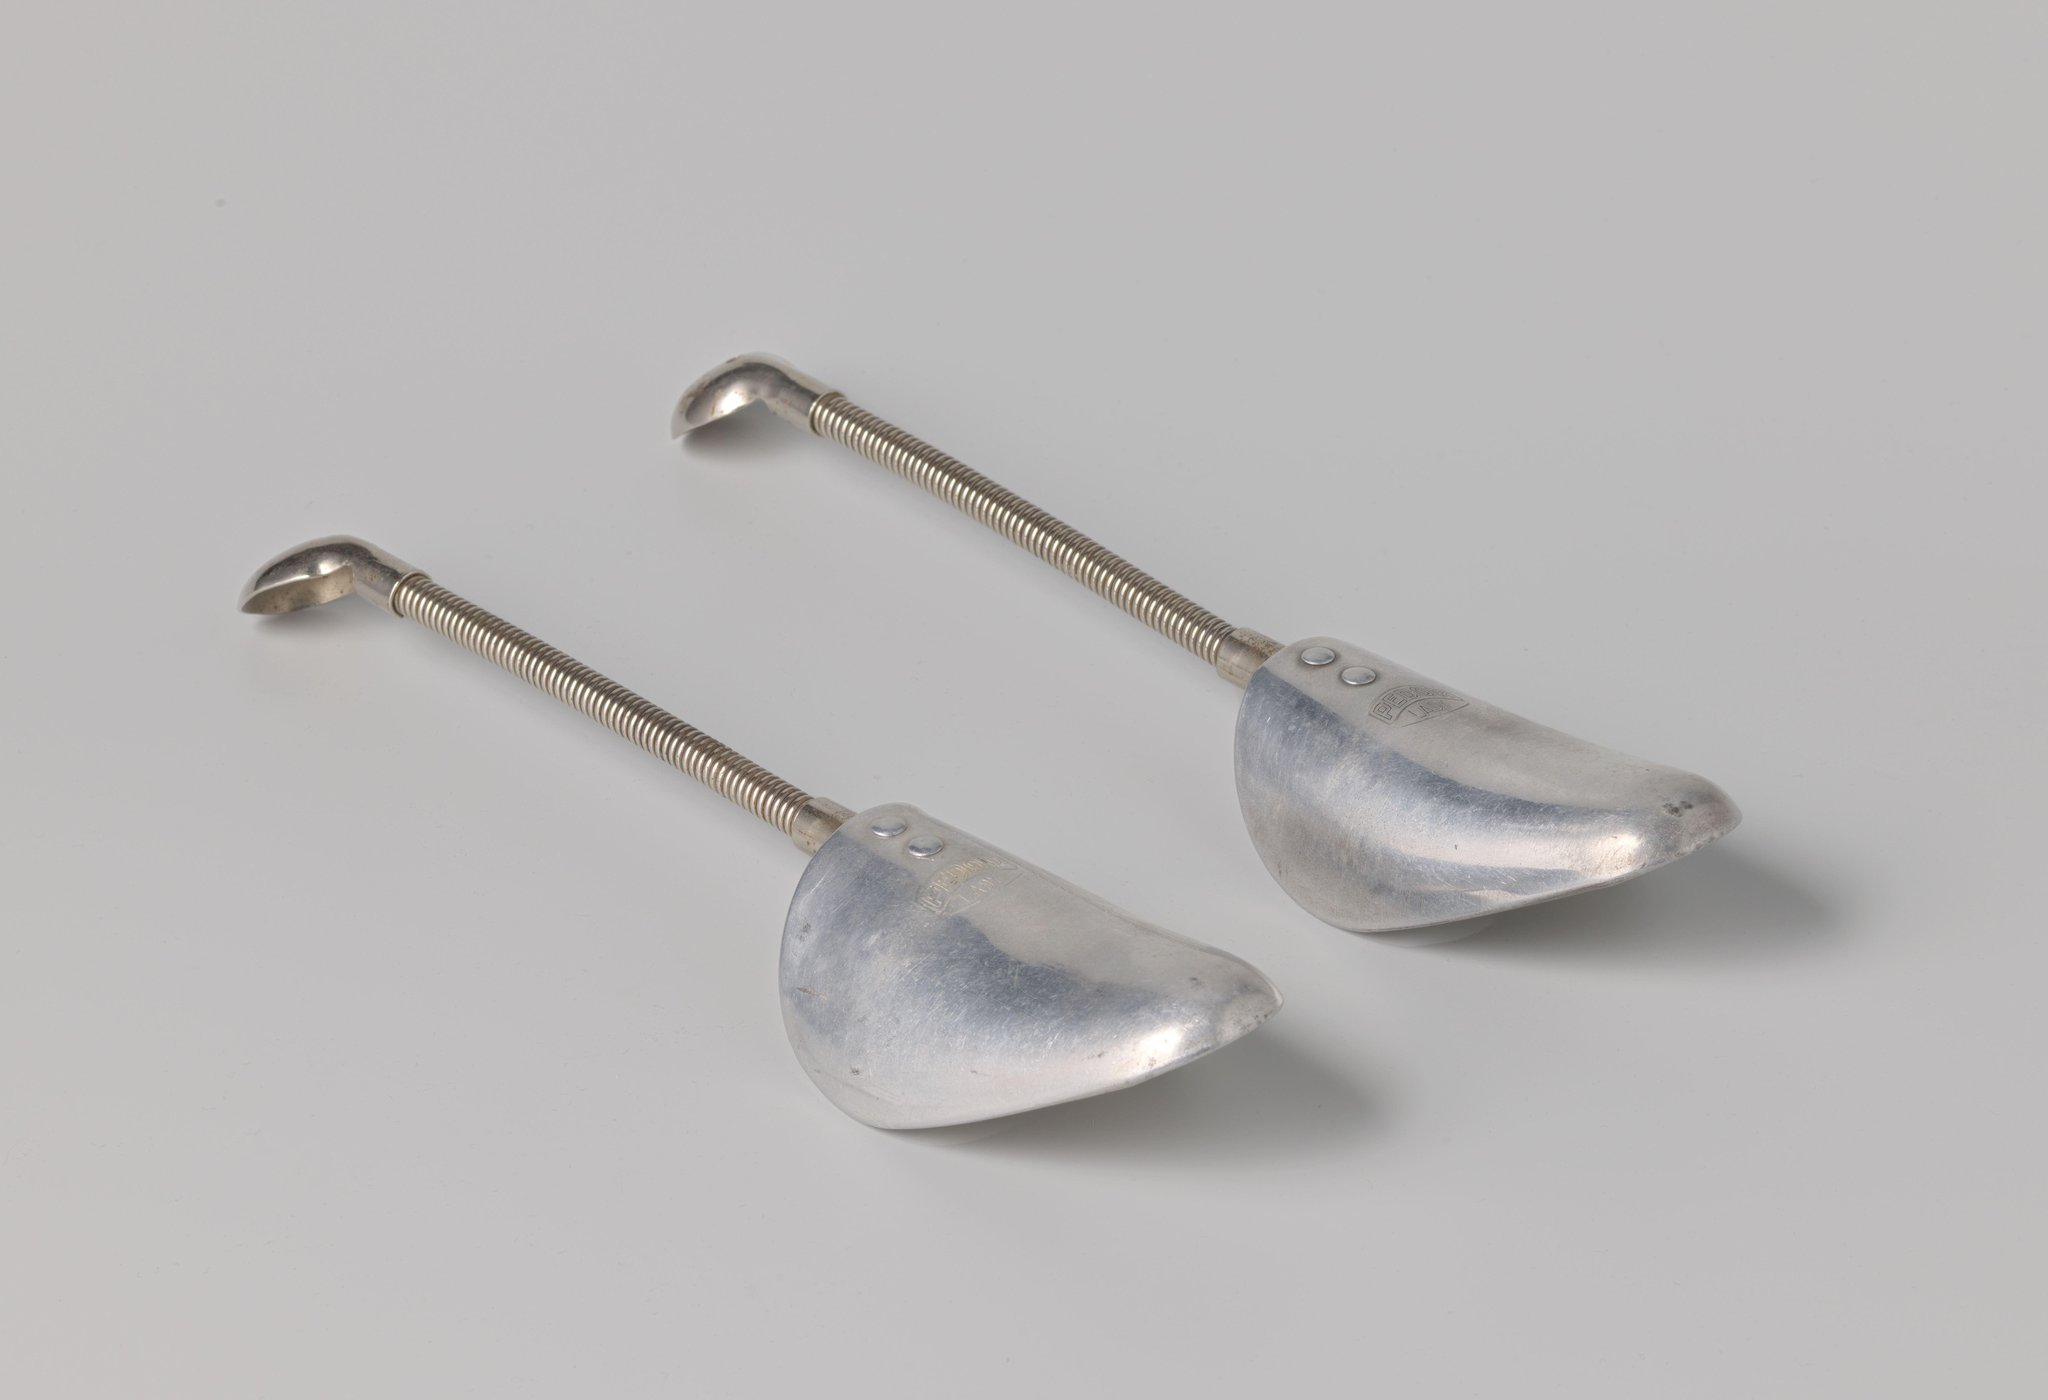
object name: shoe stretcher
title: Damesschoenspanner van metaal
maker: pedor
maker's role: schoenenfabrikant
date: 1940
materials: metal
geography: western europe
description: Linkerschoenspanner van metaal, op de wreef het merk pedor lady gestempend.